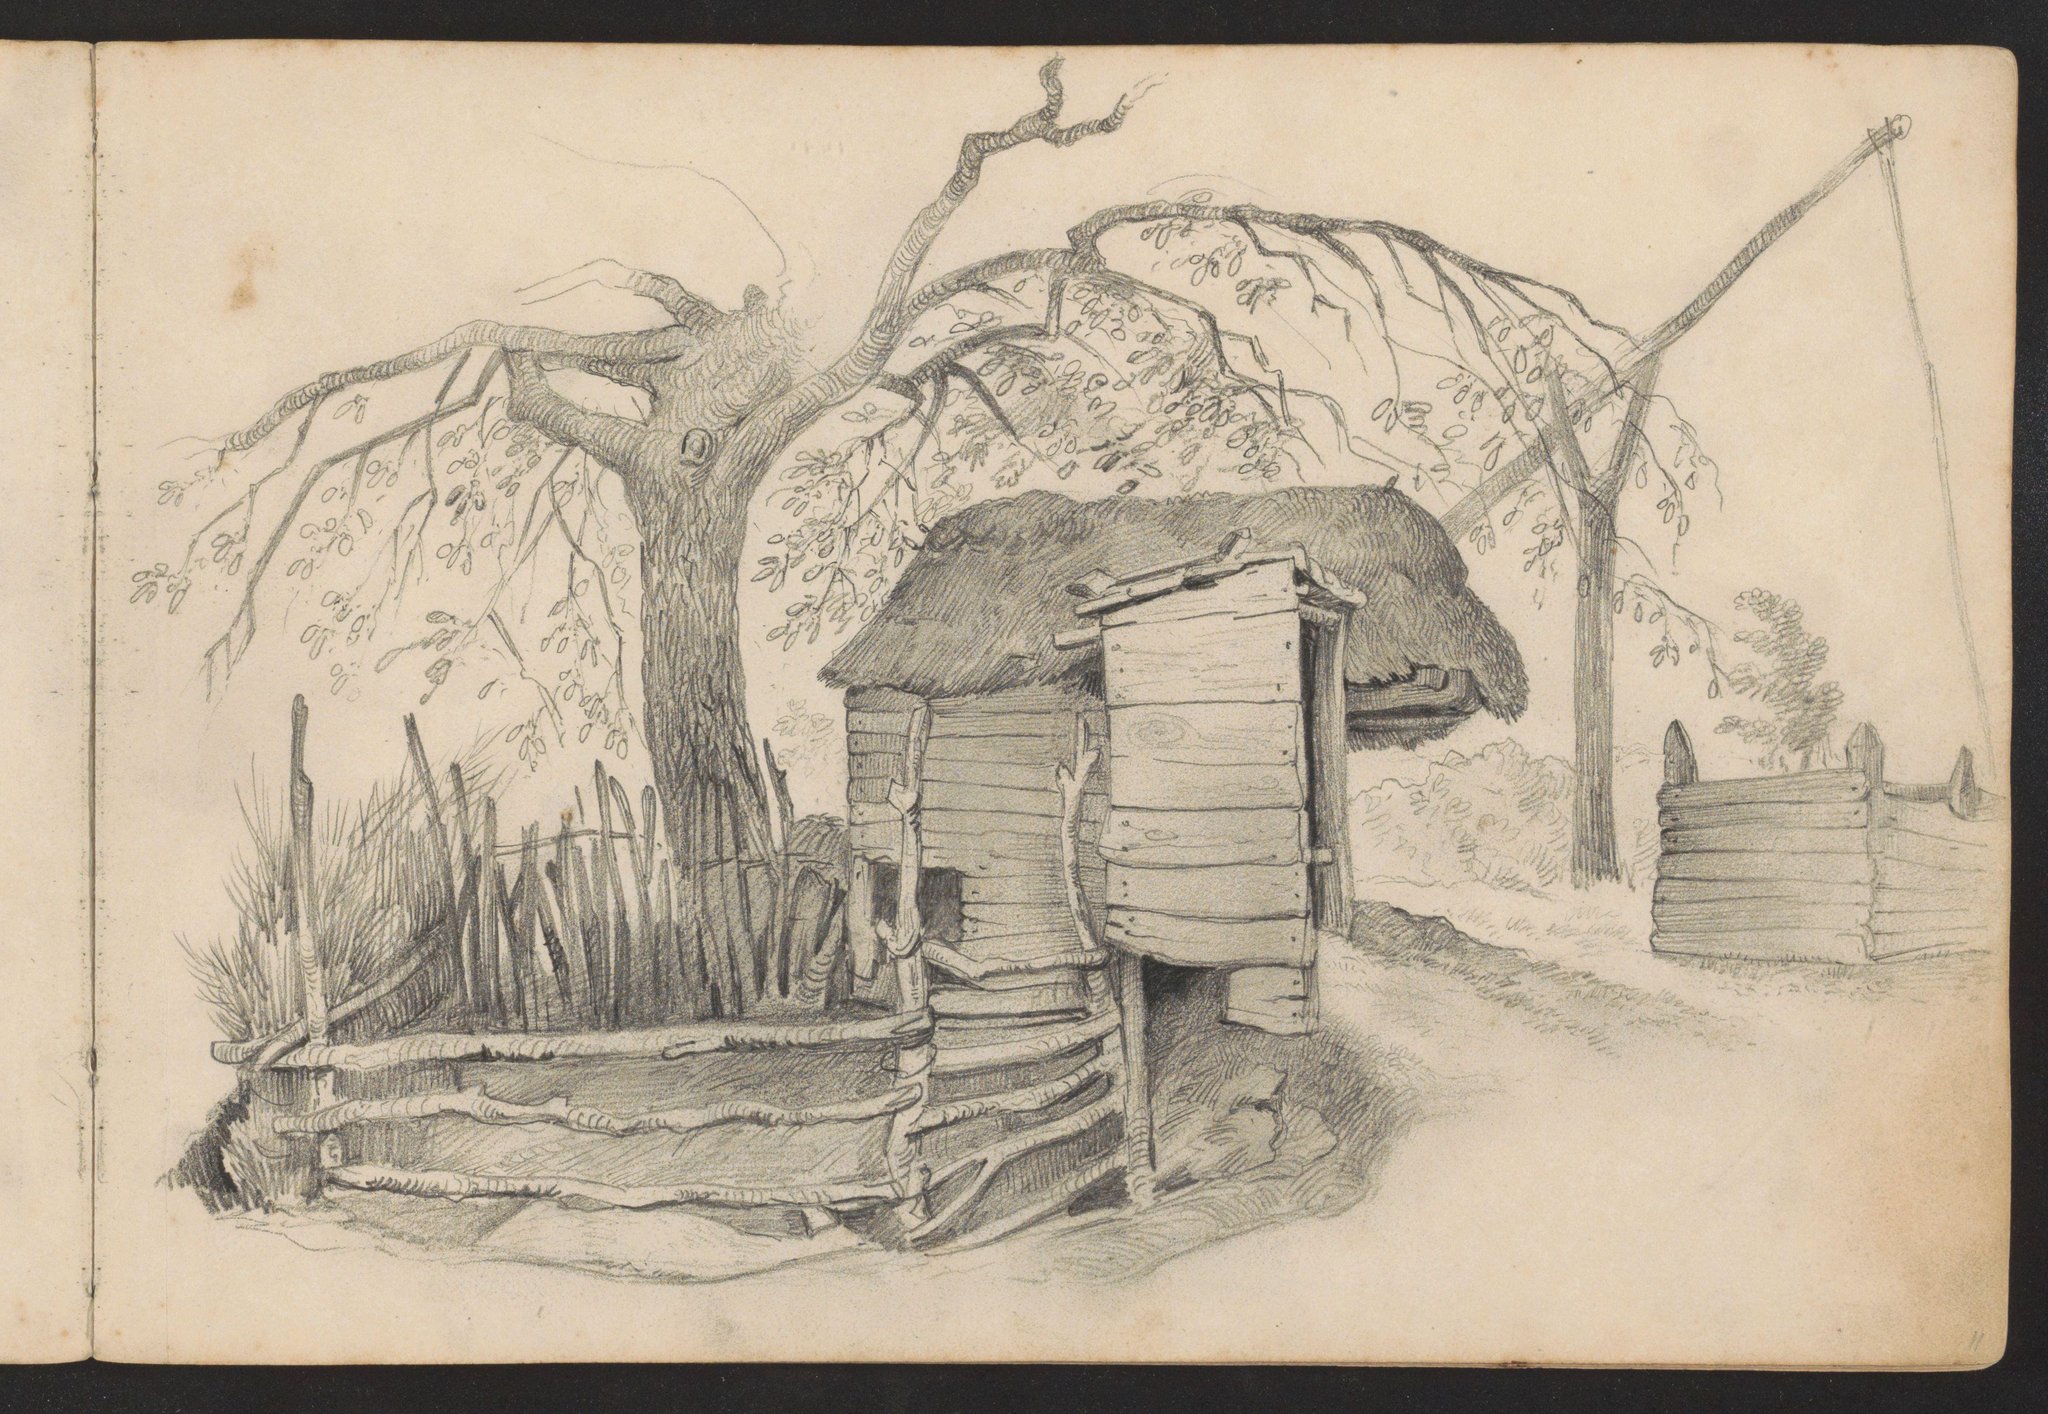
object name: sketchbook leaf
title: Stal met een omheining bij een boom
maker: johannes tavenraat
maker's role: draughtsman, painter, print maker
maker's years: 1809-1881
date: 1842-1868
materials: paper, pencil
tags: trees, fence, wall, paling, stall, stable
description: Op de achtergrond mogelijk een waterput. Blad 11 recto uit een schetsboek met 45 bladen.